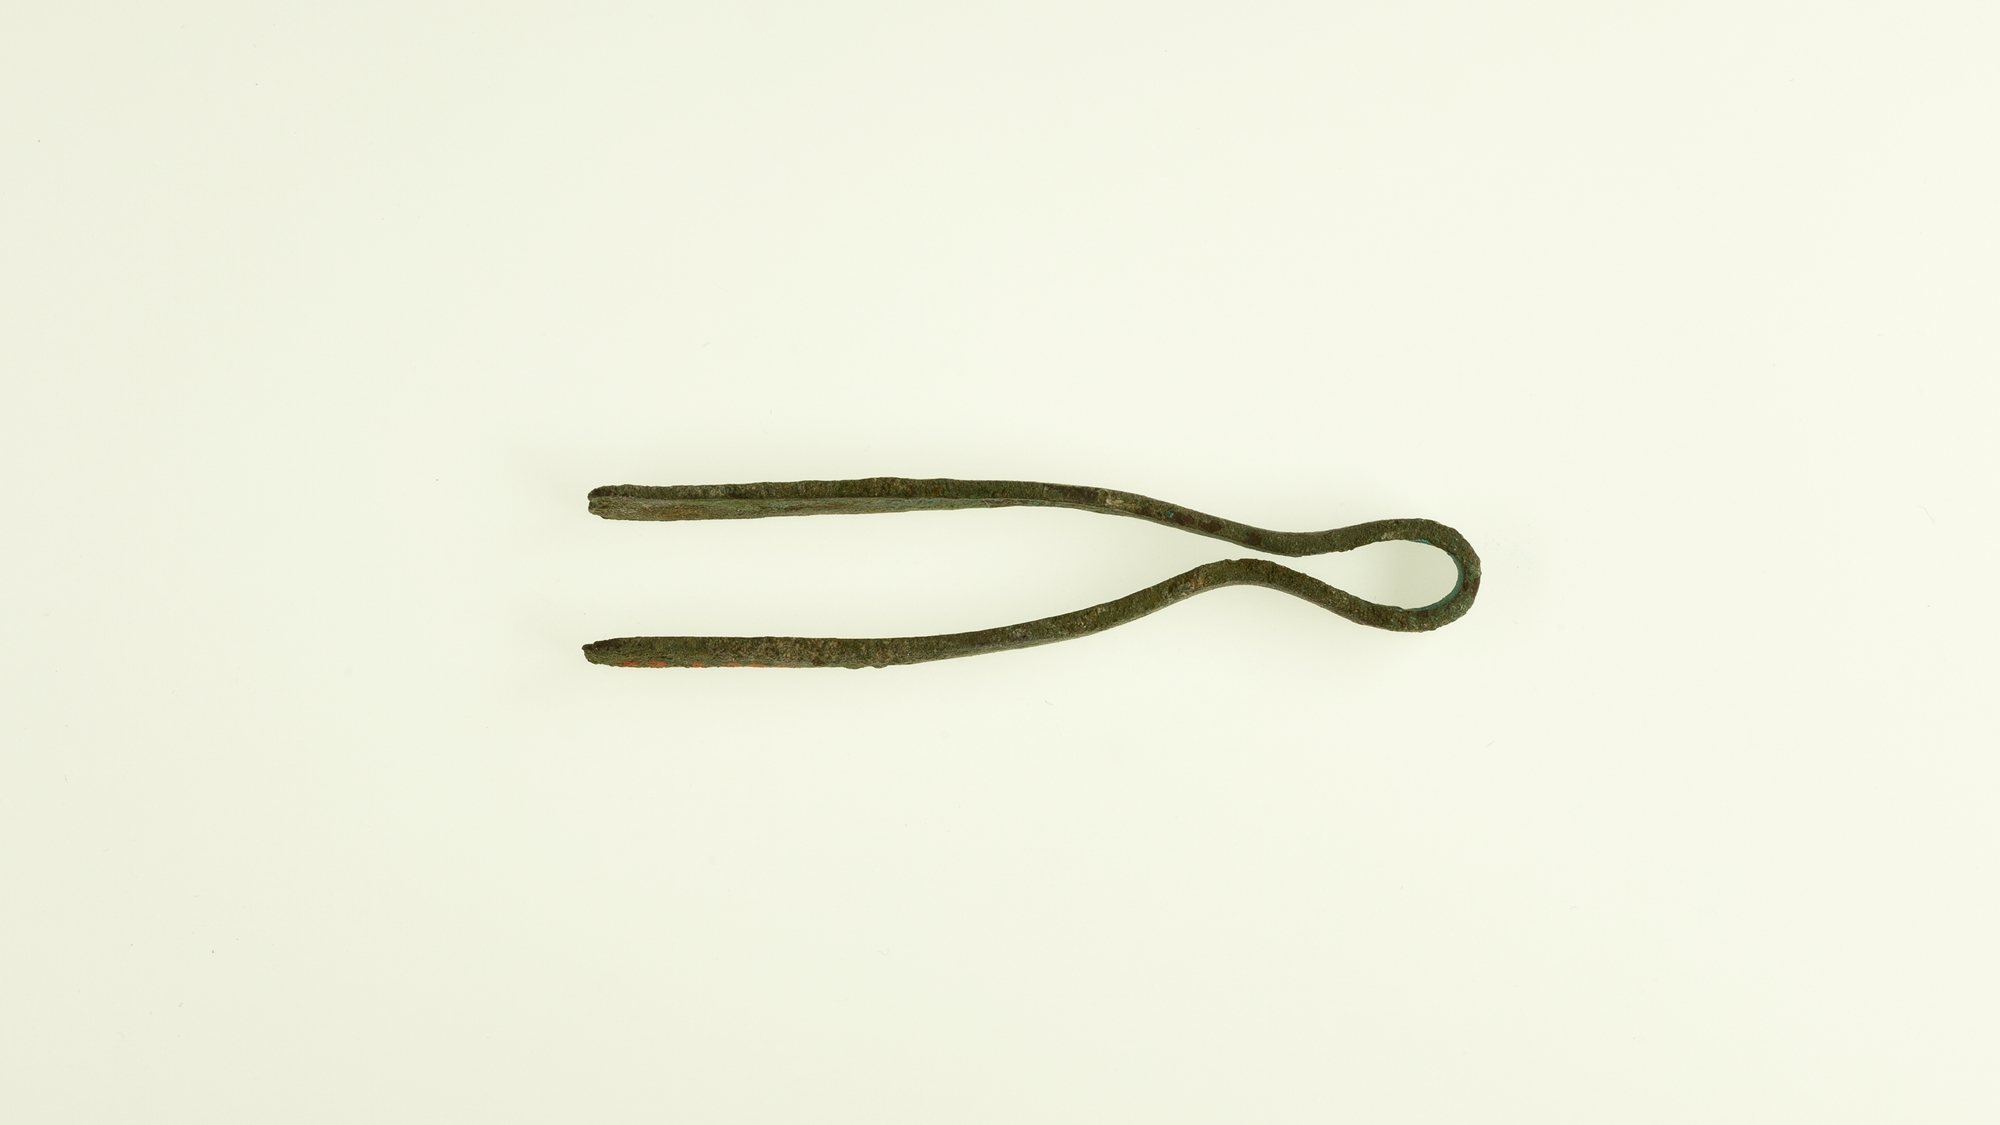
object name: tweezer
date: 1295-1070 BCE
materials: bronze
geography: egypt